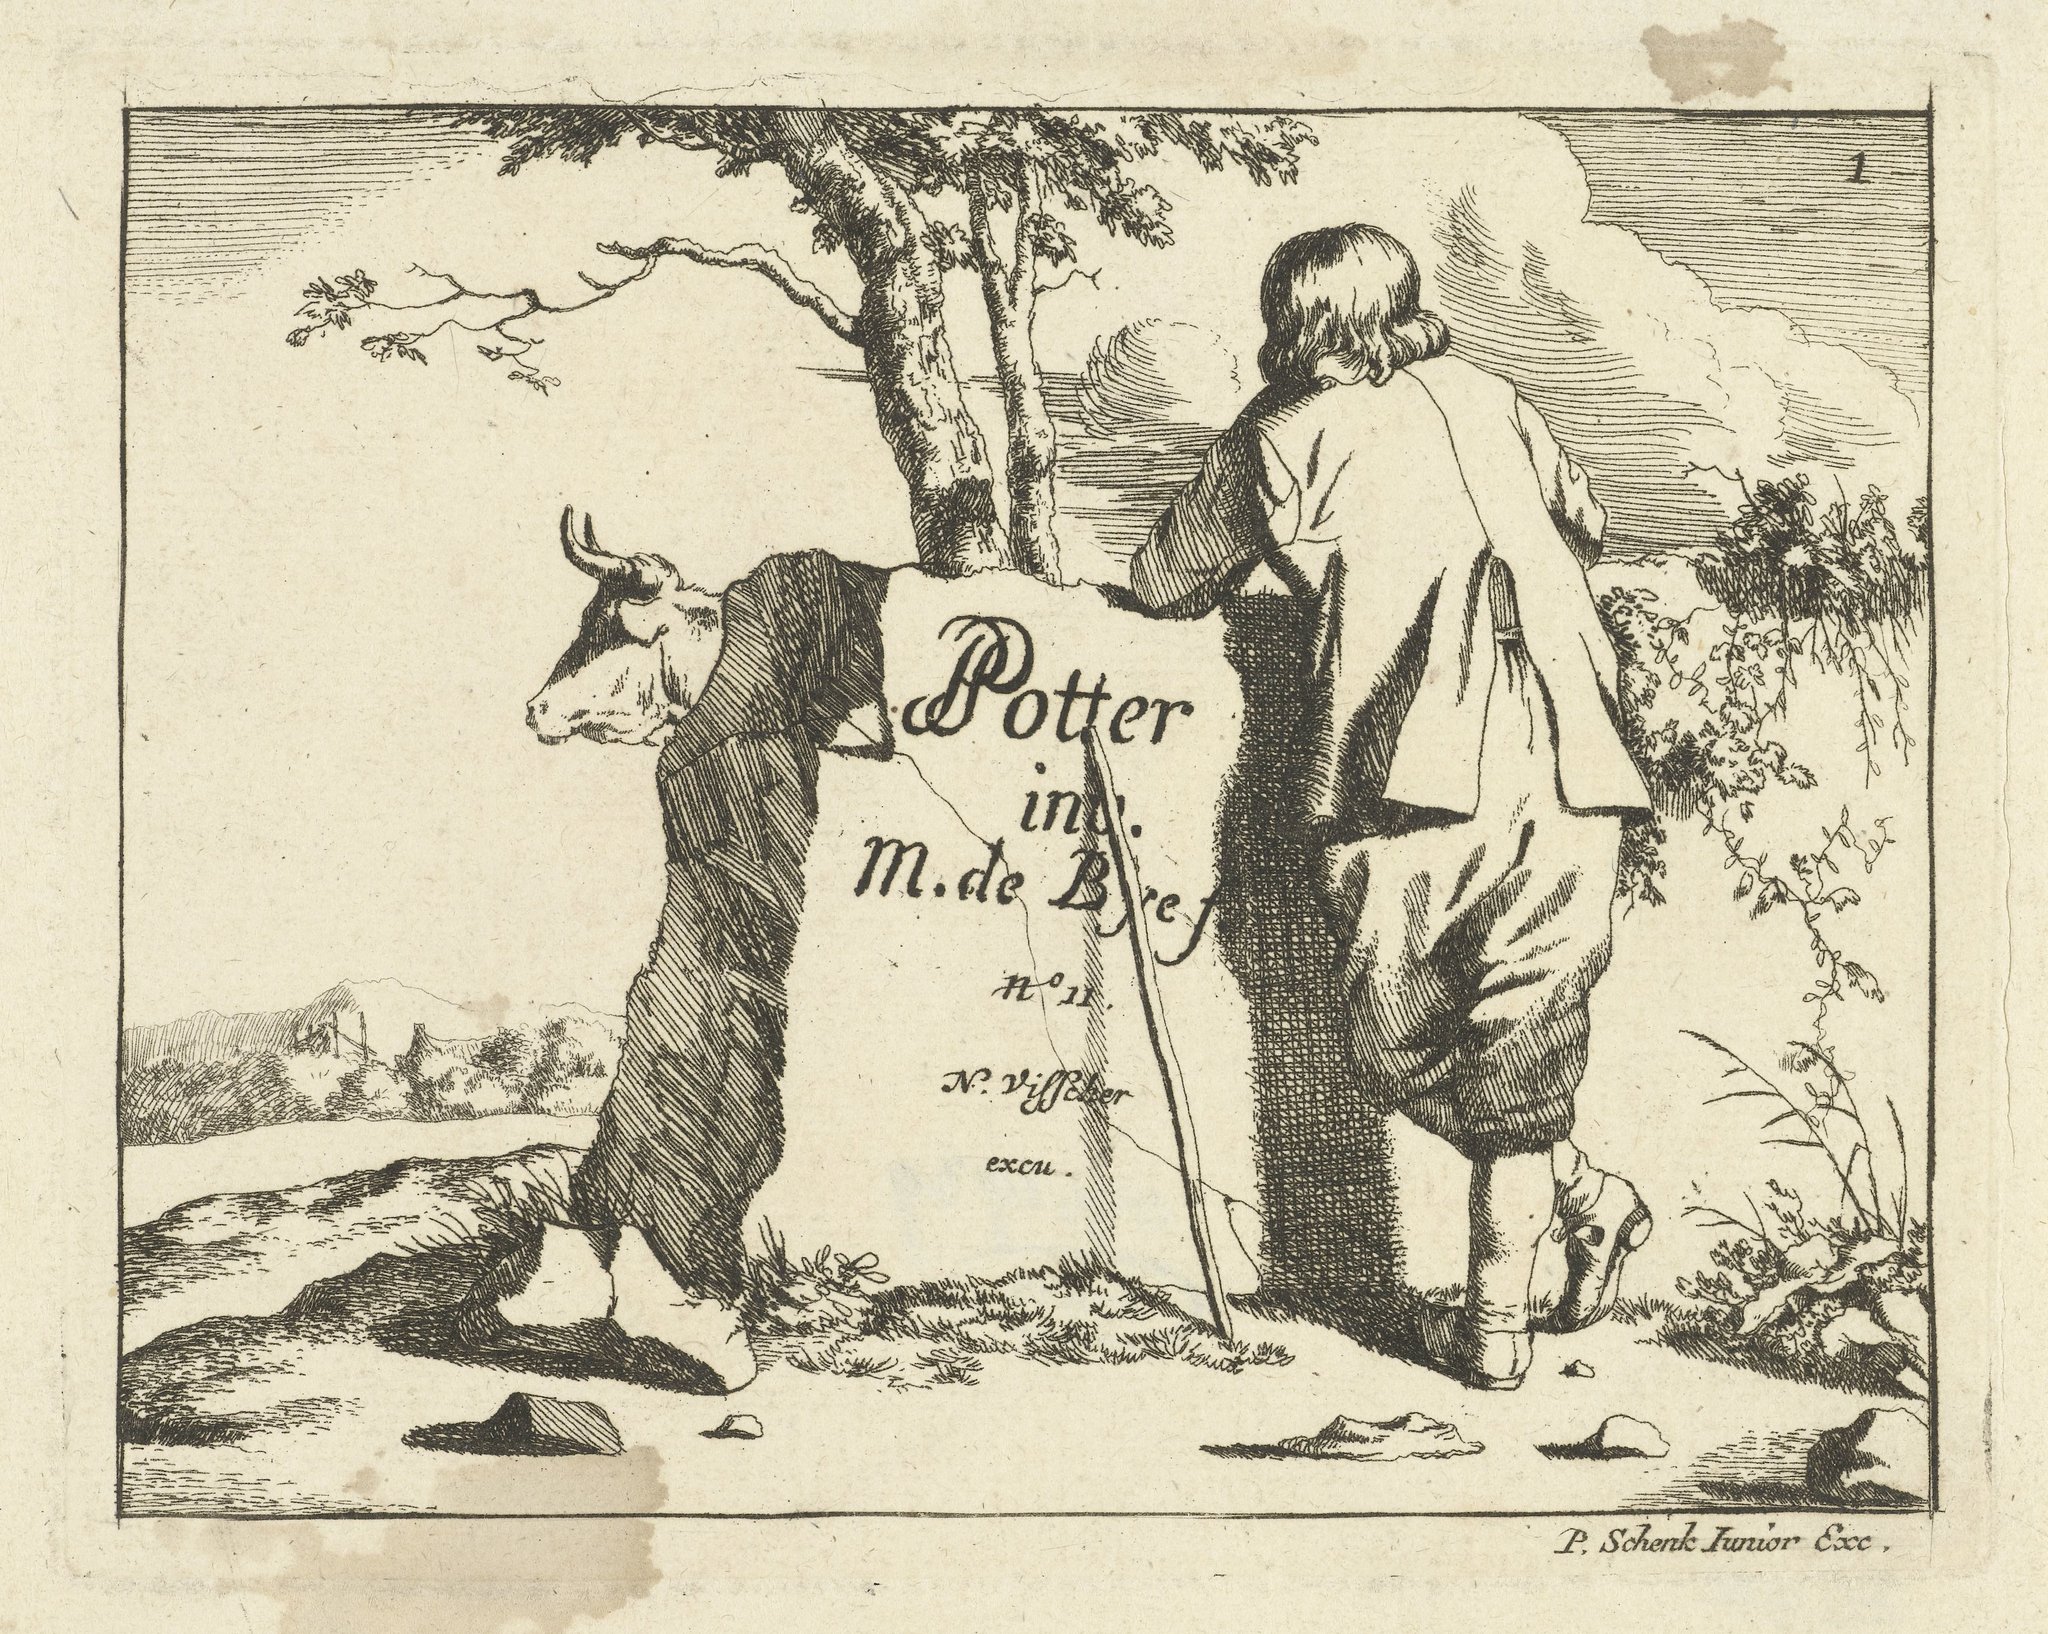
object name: print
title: Herder en rund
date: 1728-1761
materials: paper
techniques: etching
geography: the hague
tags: cow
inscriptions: collector's mark: Lugt 2228